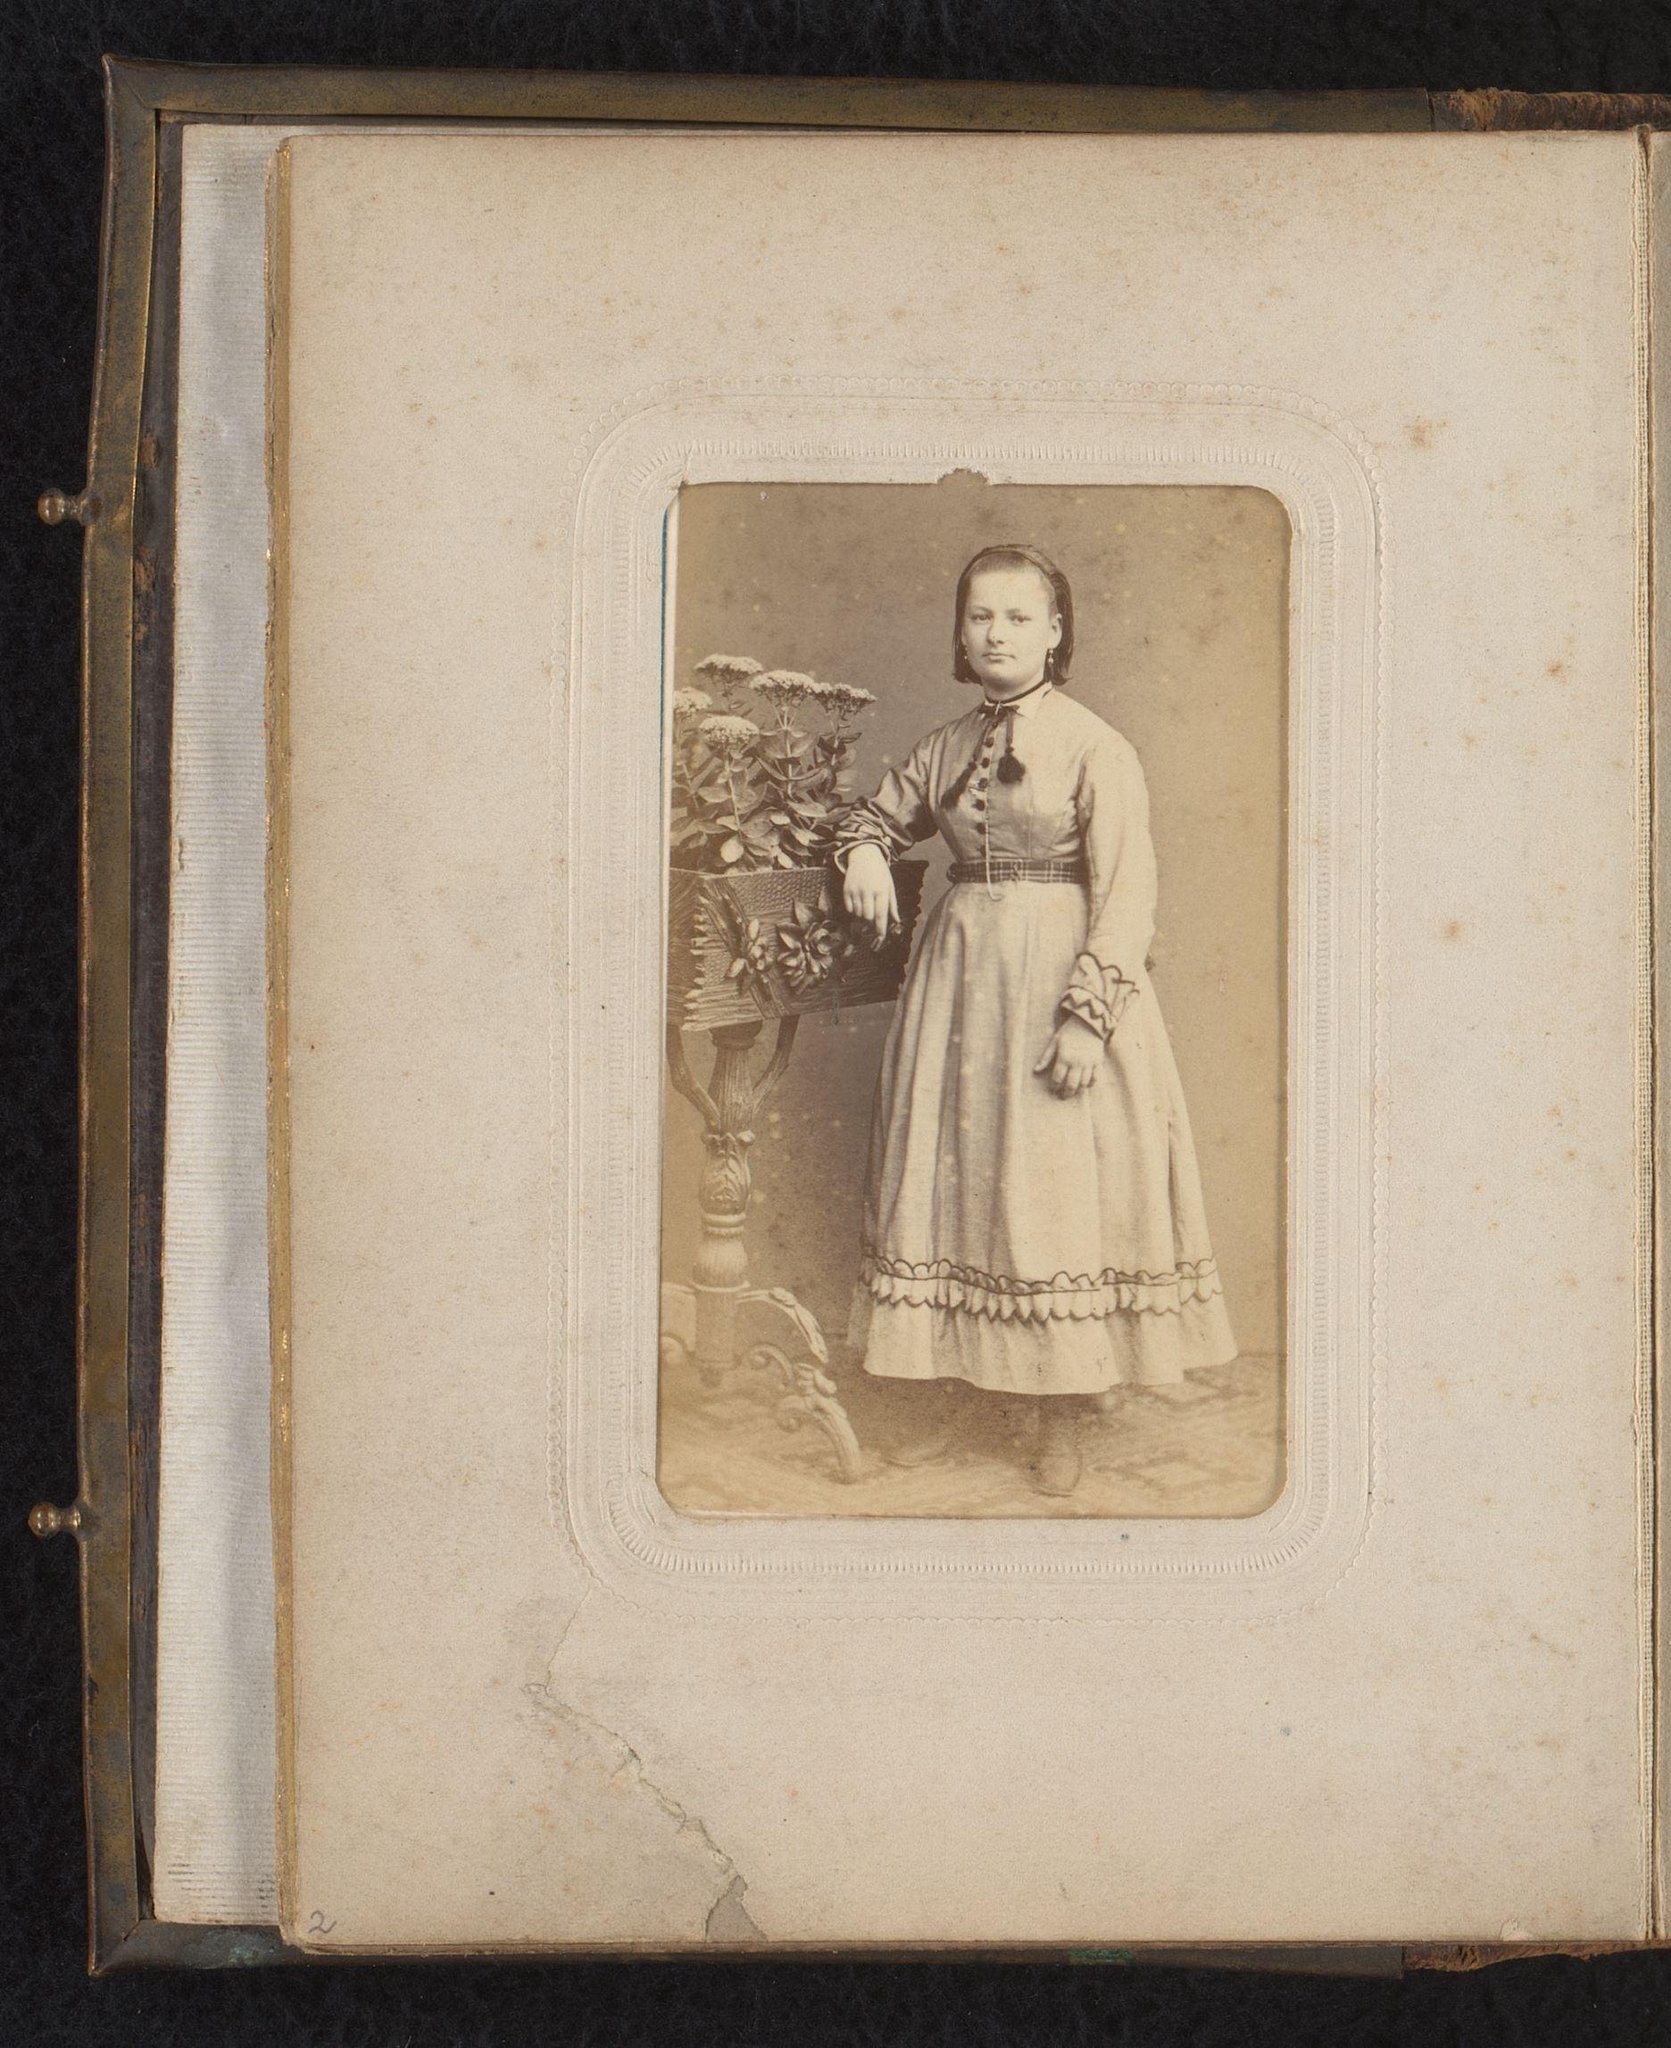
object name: album leaf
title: Portret van een meisje, staand bij een meubel met bloemen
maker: jean bourens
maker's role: fotograaf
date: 1860-1900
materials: cardboard, photographic support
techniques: albumen print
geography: metz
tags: flowers, historical persons - bb - woman, girl (child between toddler and youth), standing figure - aa - female human figure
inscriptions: inscription: ‘J. BOURENS/ Photographe/ Rue Serpenoise/ Nos. 27 et 29/ METZ/ Les Clichés sont conservés pendant 3 ans.’